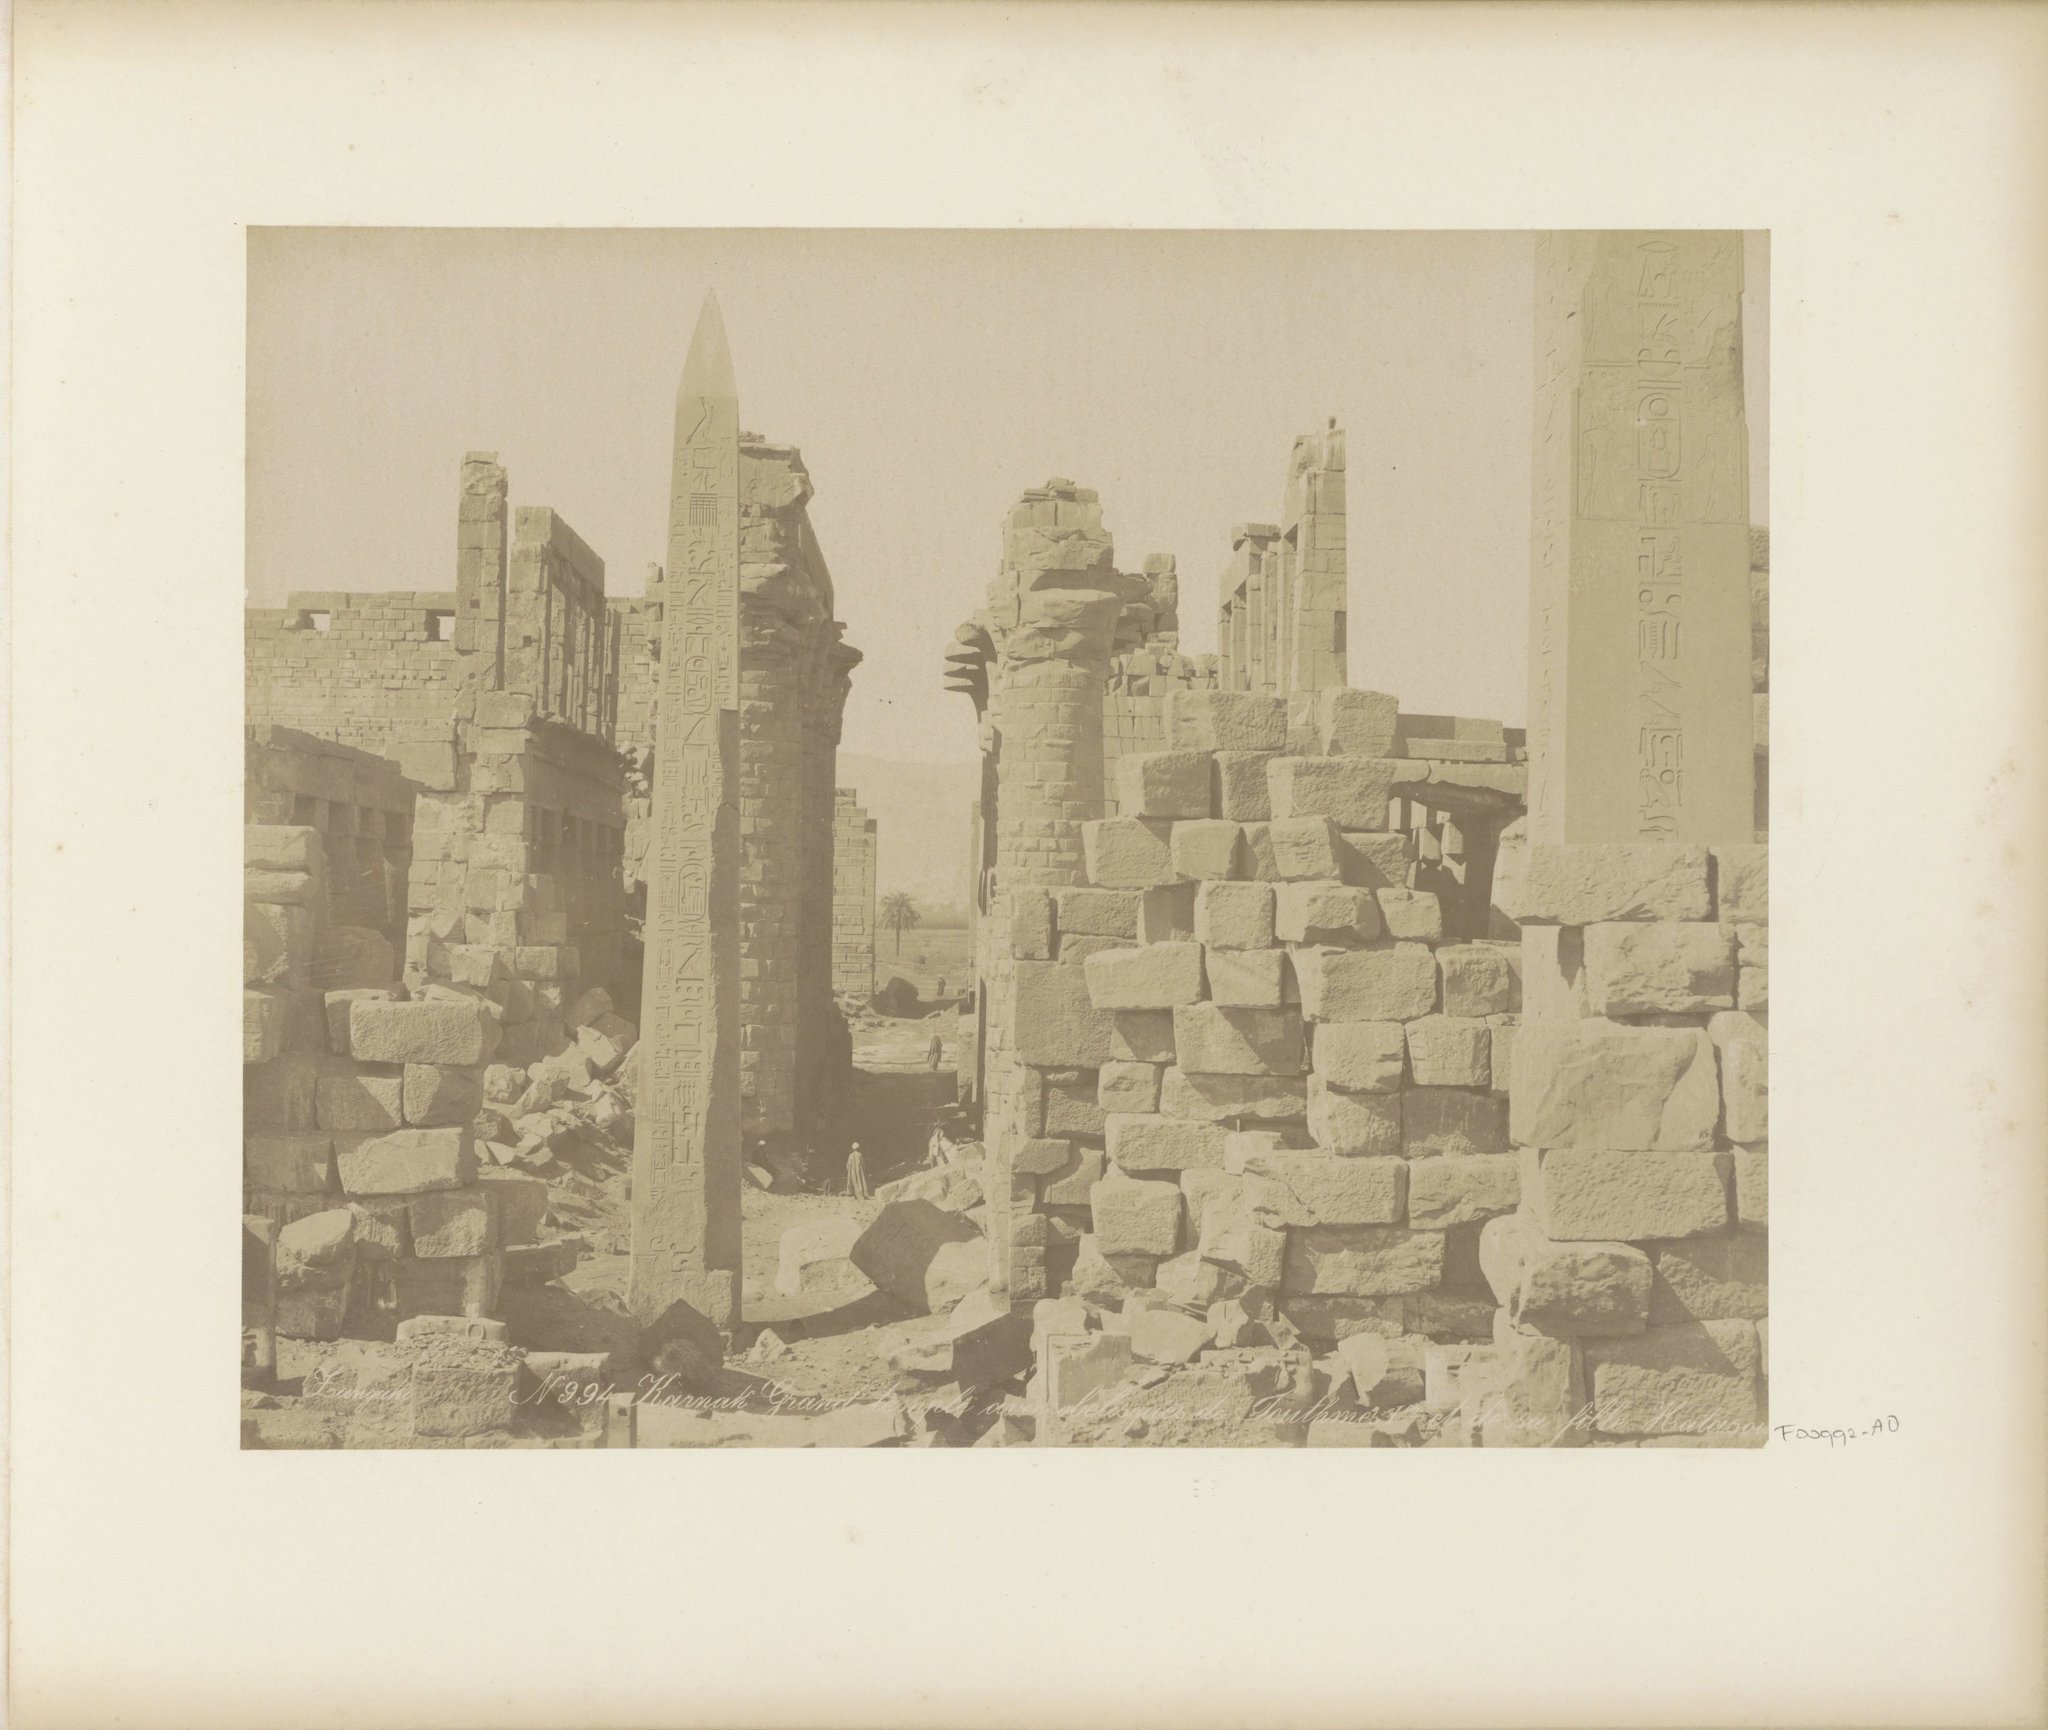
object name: photograph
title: Karnak Grand temple avec obélisques de Touthmes 1er et de sa fille Hatasou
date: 1870-1890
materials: cardboard, paper, photographic support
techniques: albumen print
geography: luxor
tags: obelisk, needle, temple, shrine ~ egyptian religion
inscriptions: negative number: ‘994’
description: Onderdeel van Reisalbum met 80 foto's van Egypte.